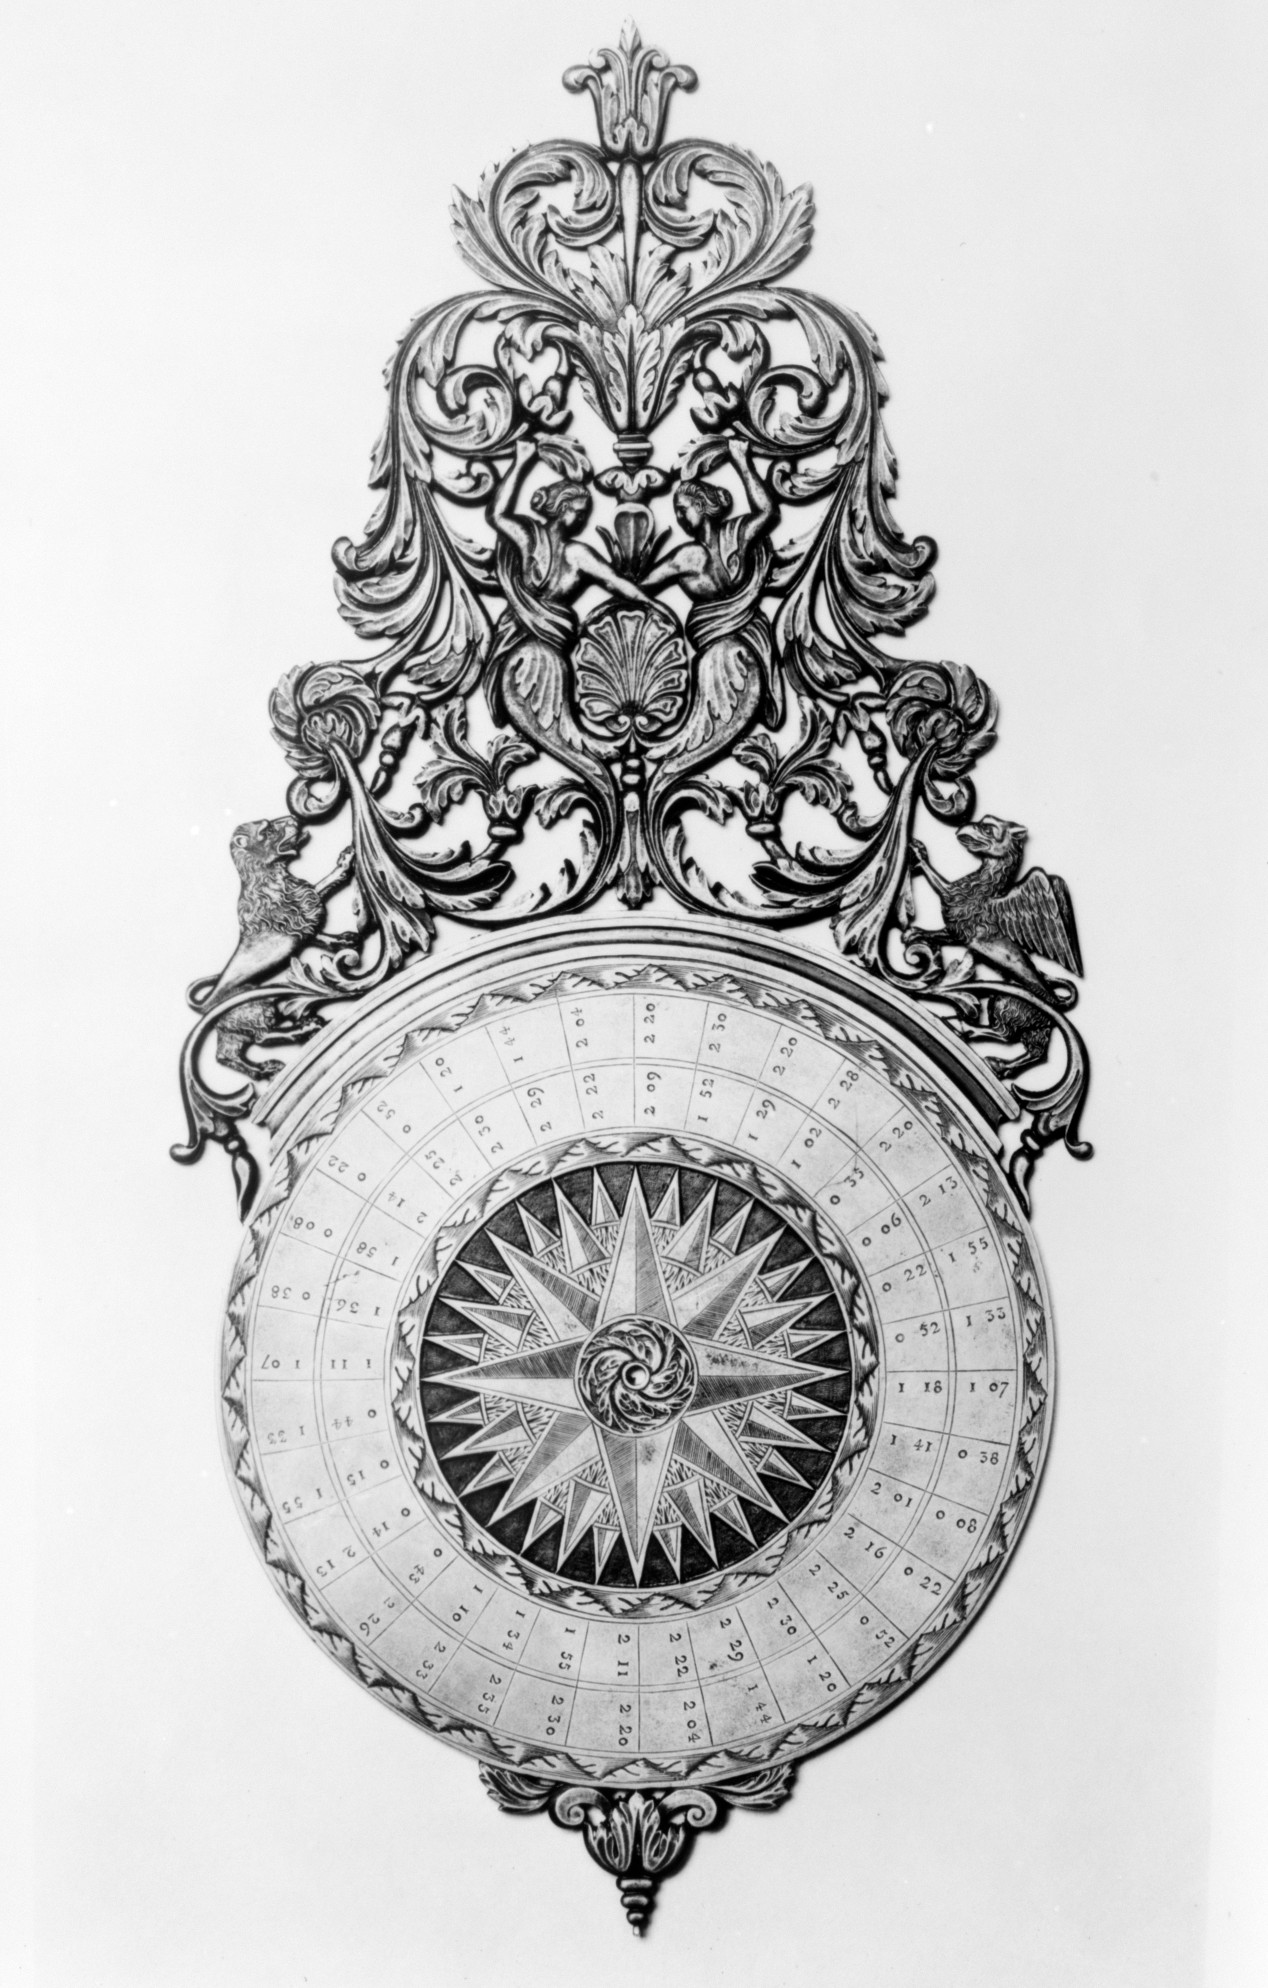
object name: nocturnal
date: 1801-1900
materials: iron, silver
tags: griffins,lions,zodiac